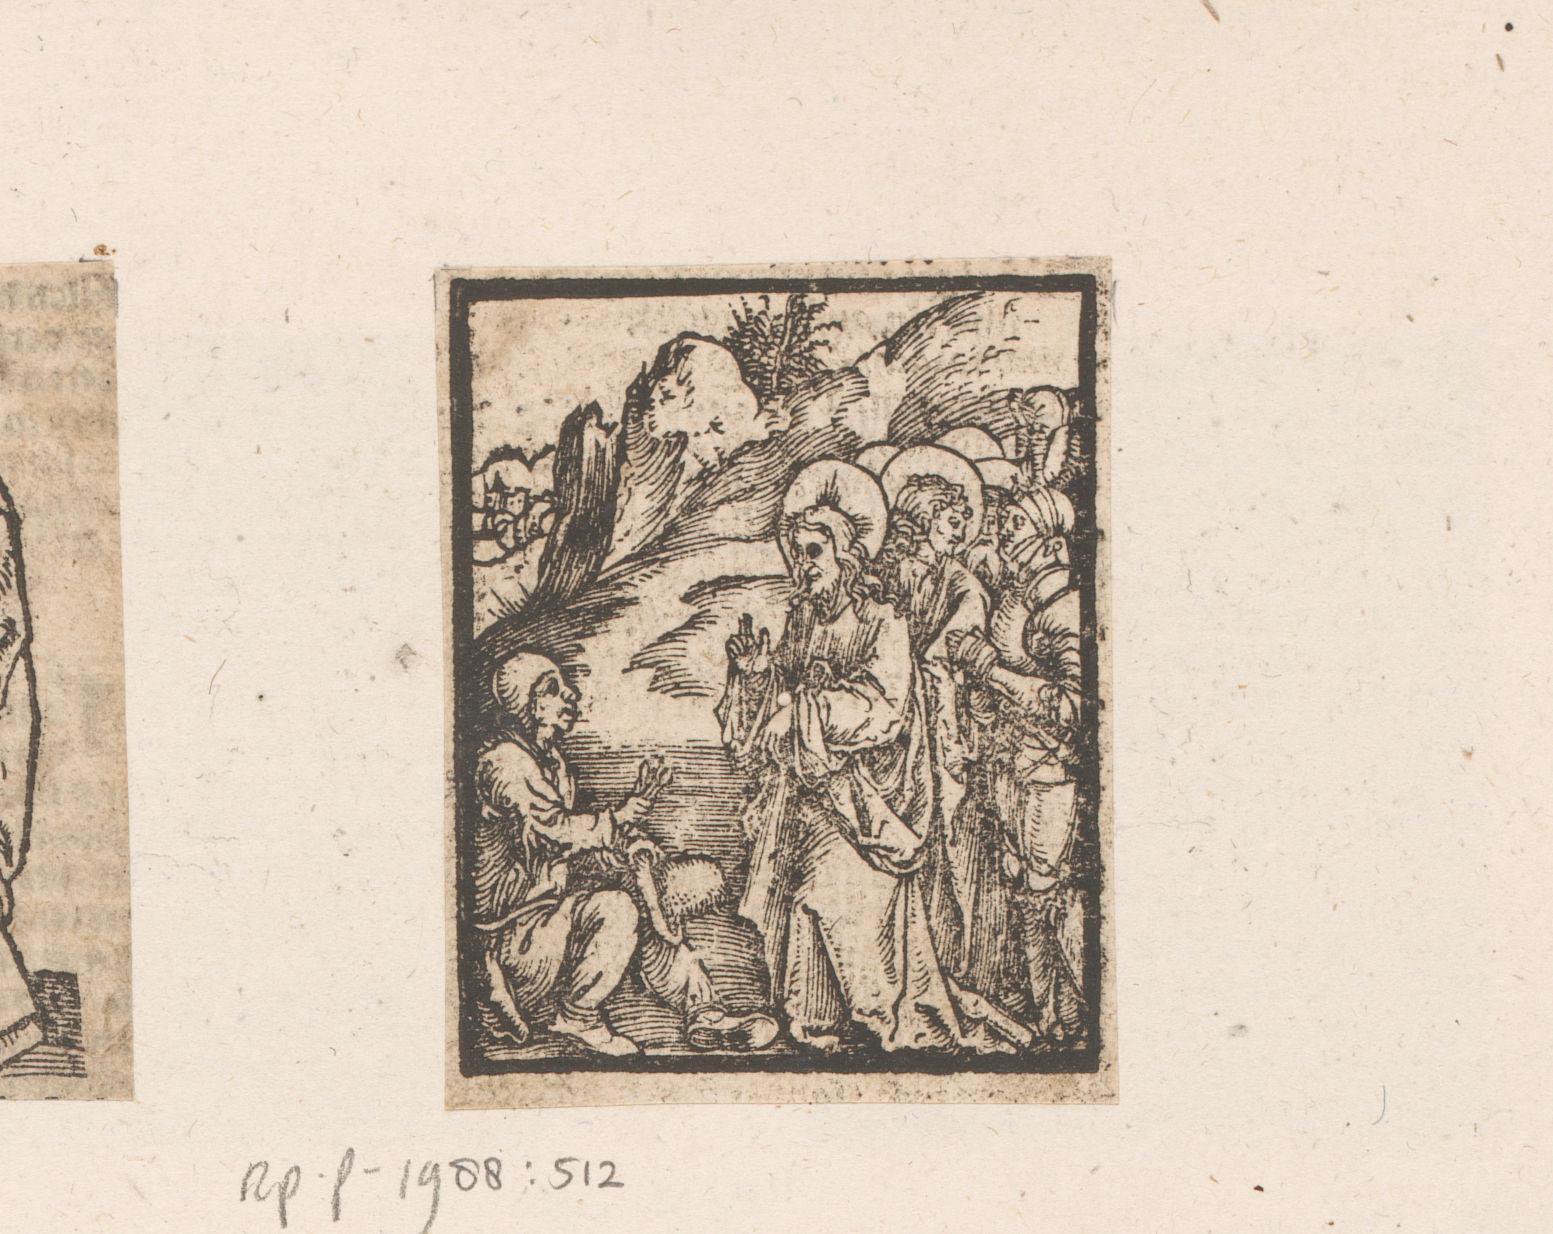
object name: print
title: Christus geneest een melaatse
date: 1536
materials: paper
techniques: woodcut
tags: christ healing lepers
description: Prent afkomstig uit: Evangelia und Epistel. Neurenberg: Hans Guldenmund, 1536.